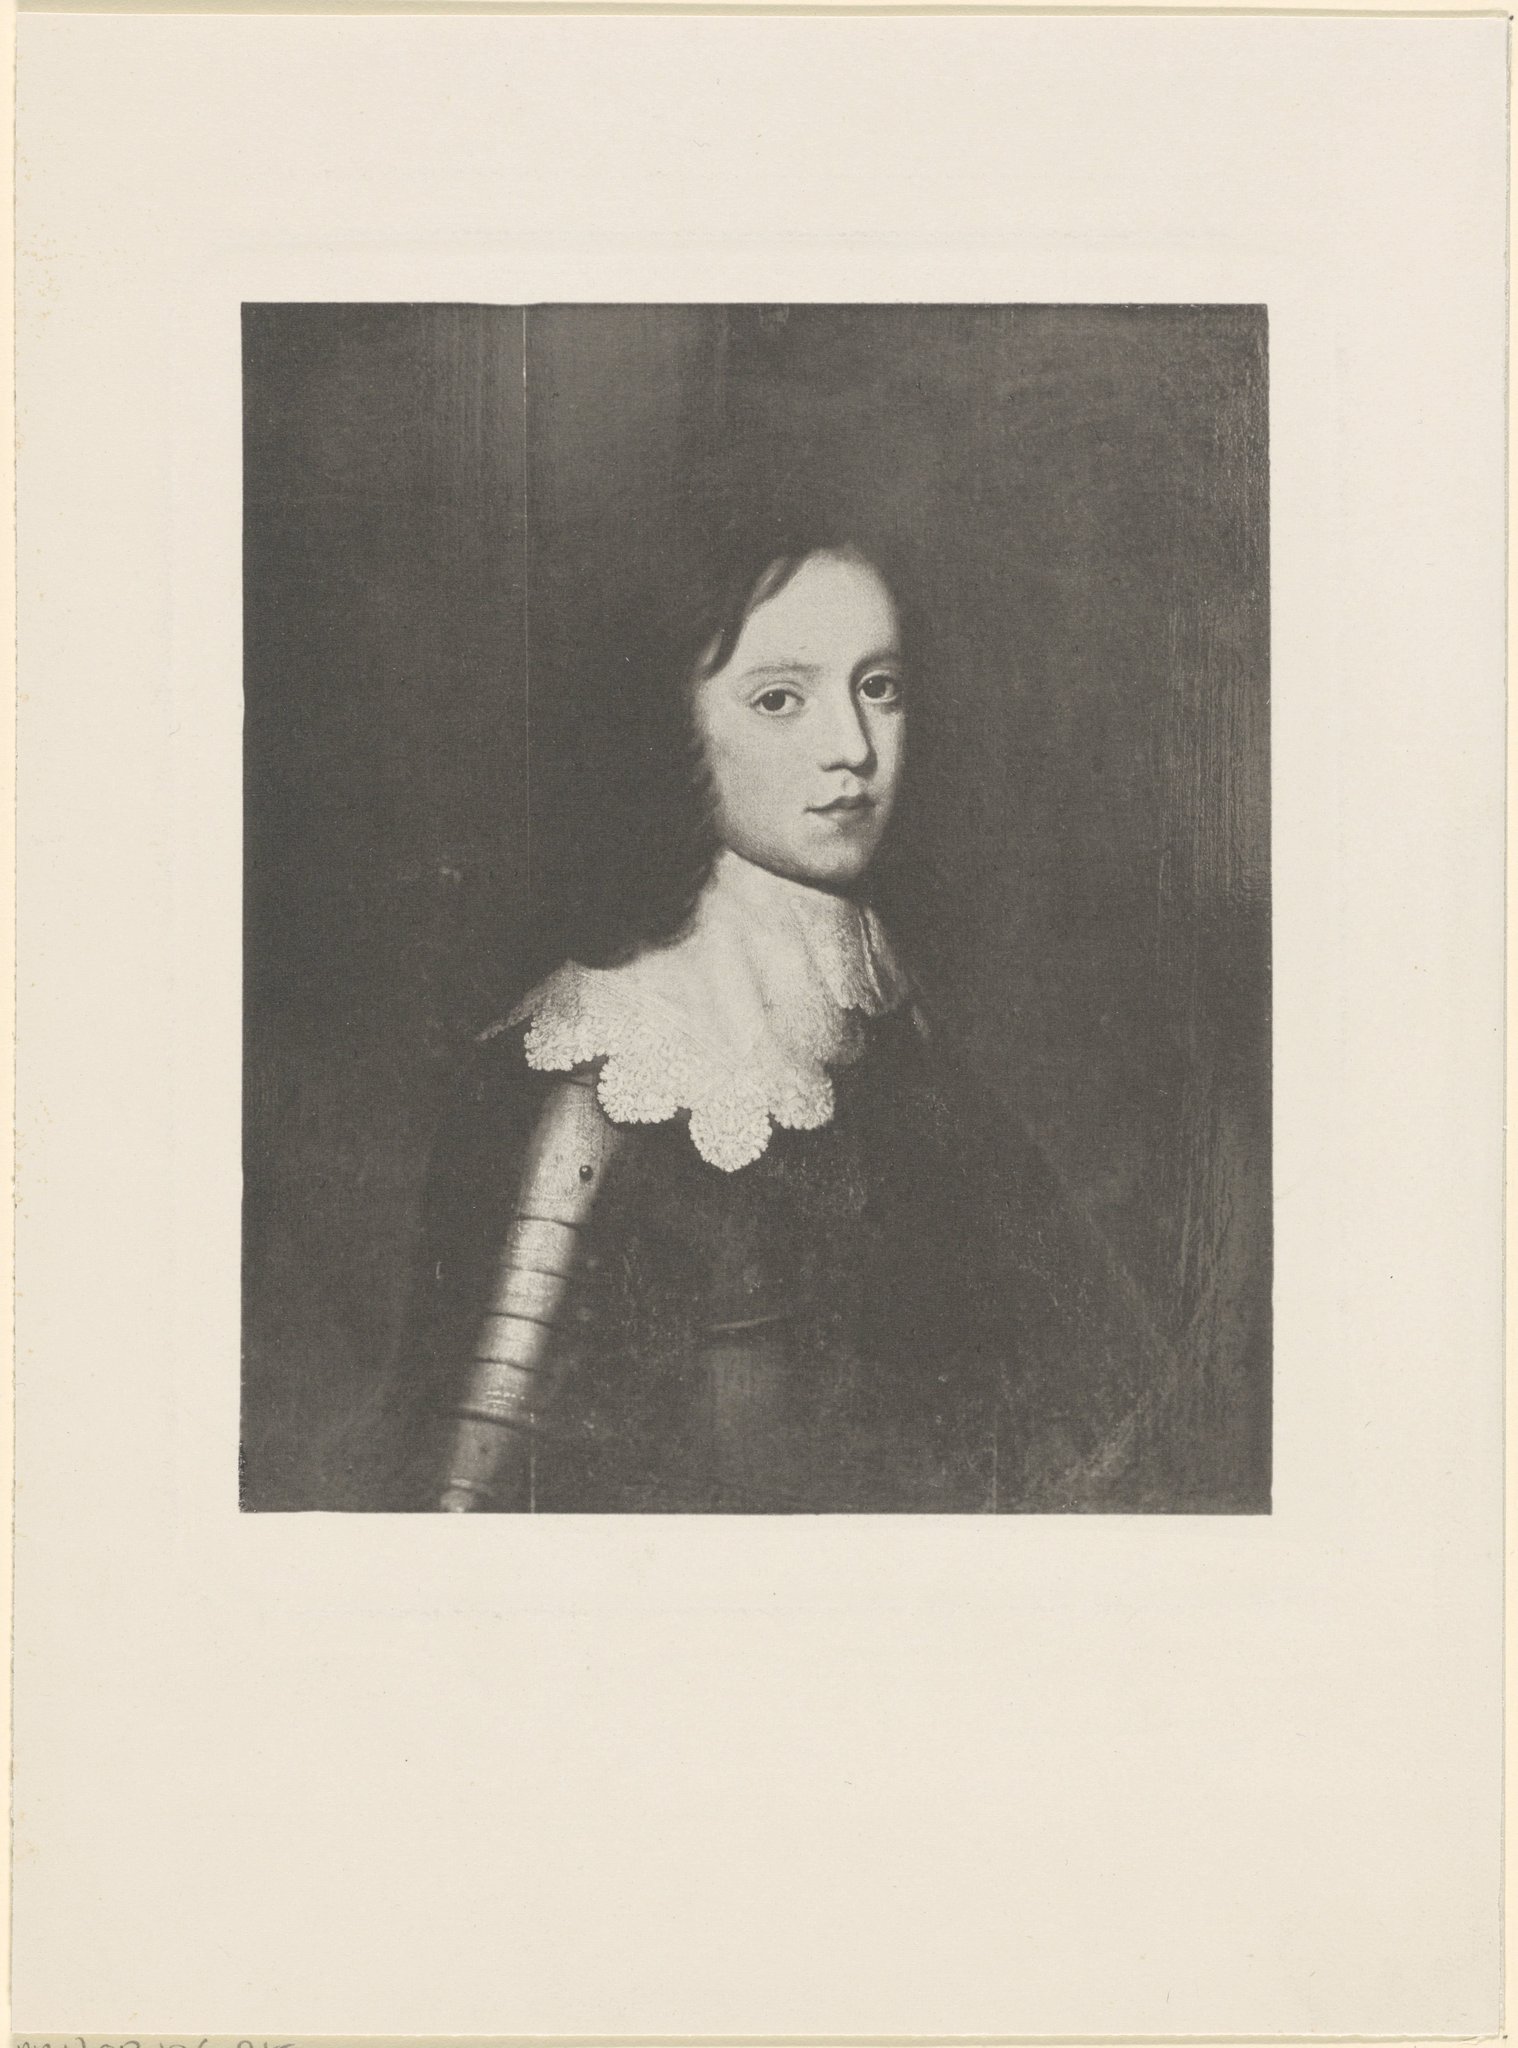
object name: photomechanical print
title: Portret van Willem III, prins van Oranje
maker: Anonymous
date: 1850-1949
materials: paper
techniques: photograph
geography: netherlands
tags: the hague, william iii (prince of orange and king of england, scotland, and ireland)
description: De hier vermelde titel verwijst naar de hoogst verkregen titel van de geportretteerde, niet per se naar de titel die de geportretteerde op deze voorstelling draagt.